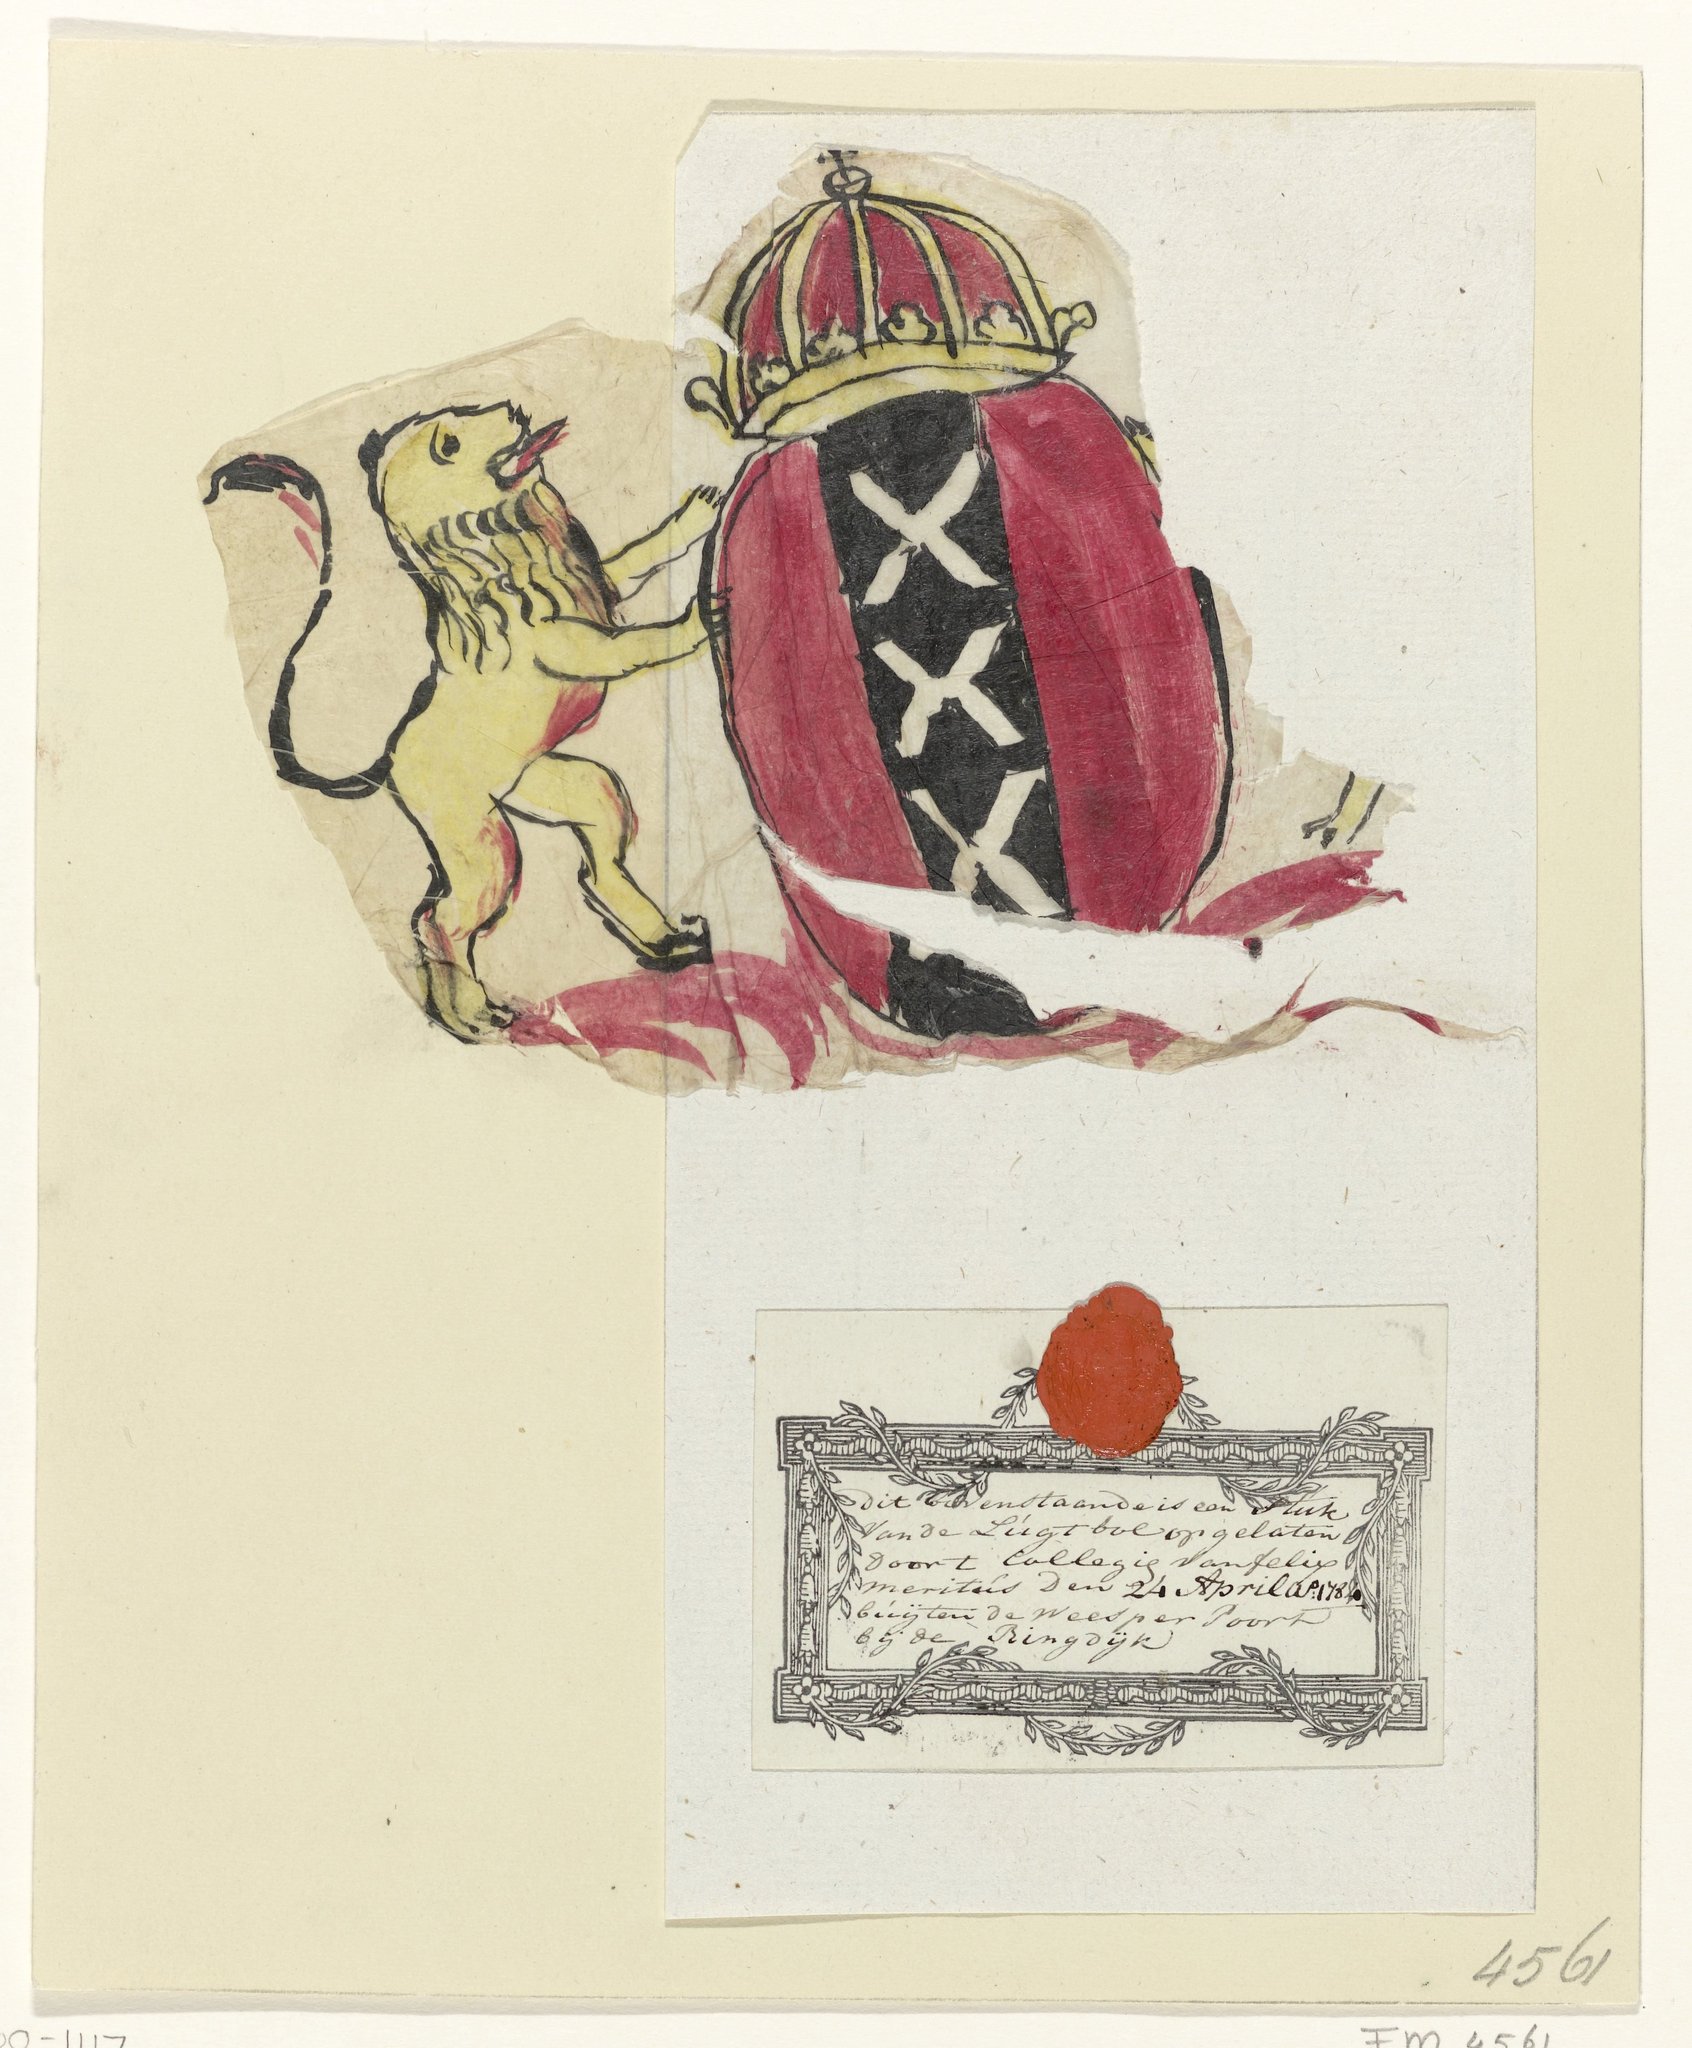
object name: painting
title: Fragment van een luchtballon, 1784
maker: Anonymous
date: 1784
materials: paint, paper, wax, silk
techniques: sealing, writing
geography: amsterdam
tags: balloon (aviation), amsterdam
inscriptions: collector's mark: Lugt 2228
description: Fragment van een luchtballon opgelaten door het collegie van Felix Meritis op 24 april 1784 buiten de Weesperpoort bij de Ringdijk te Amsterdam. Stuk zijde waarop het wapen van Amsterdam is geschilderd. Hierbij ook een bewijs van echtheid met een rode lakzegel.